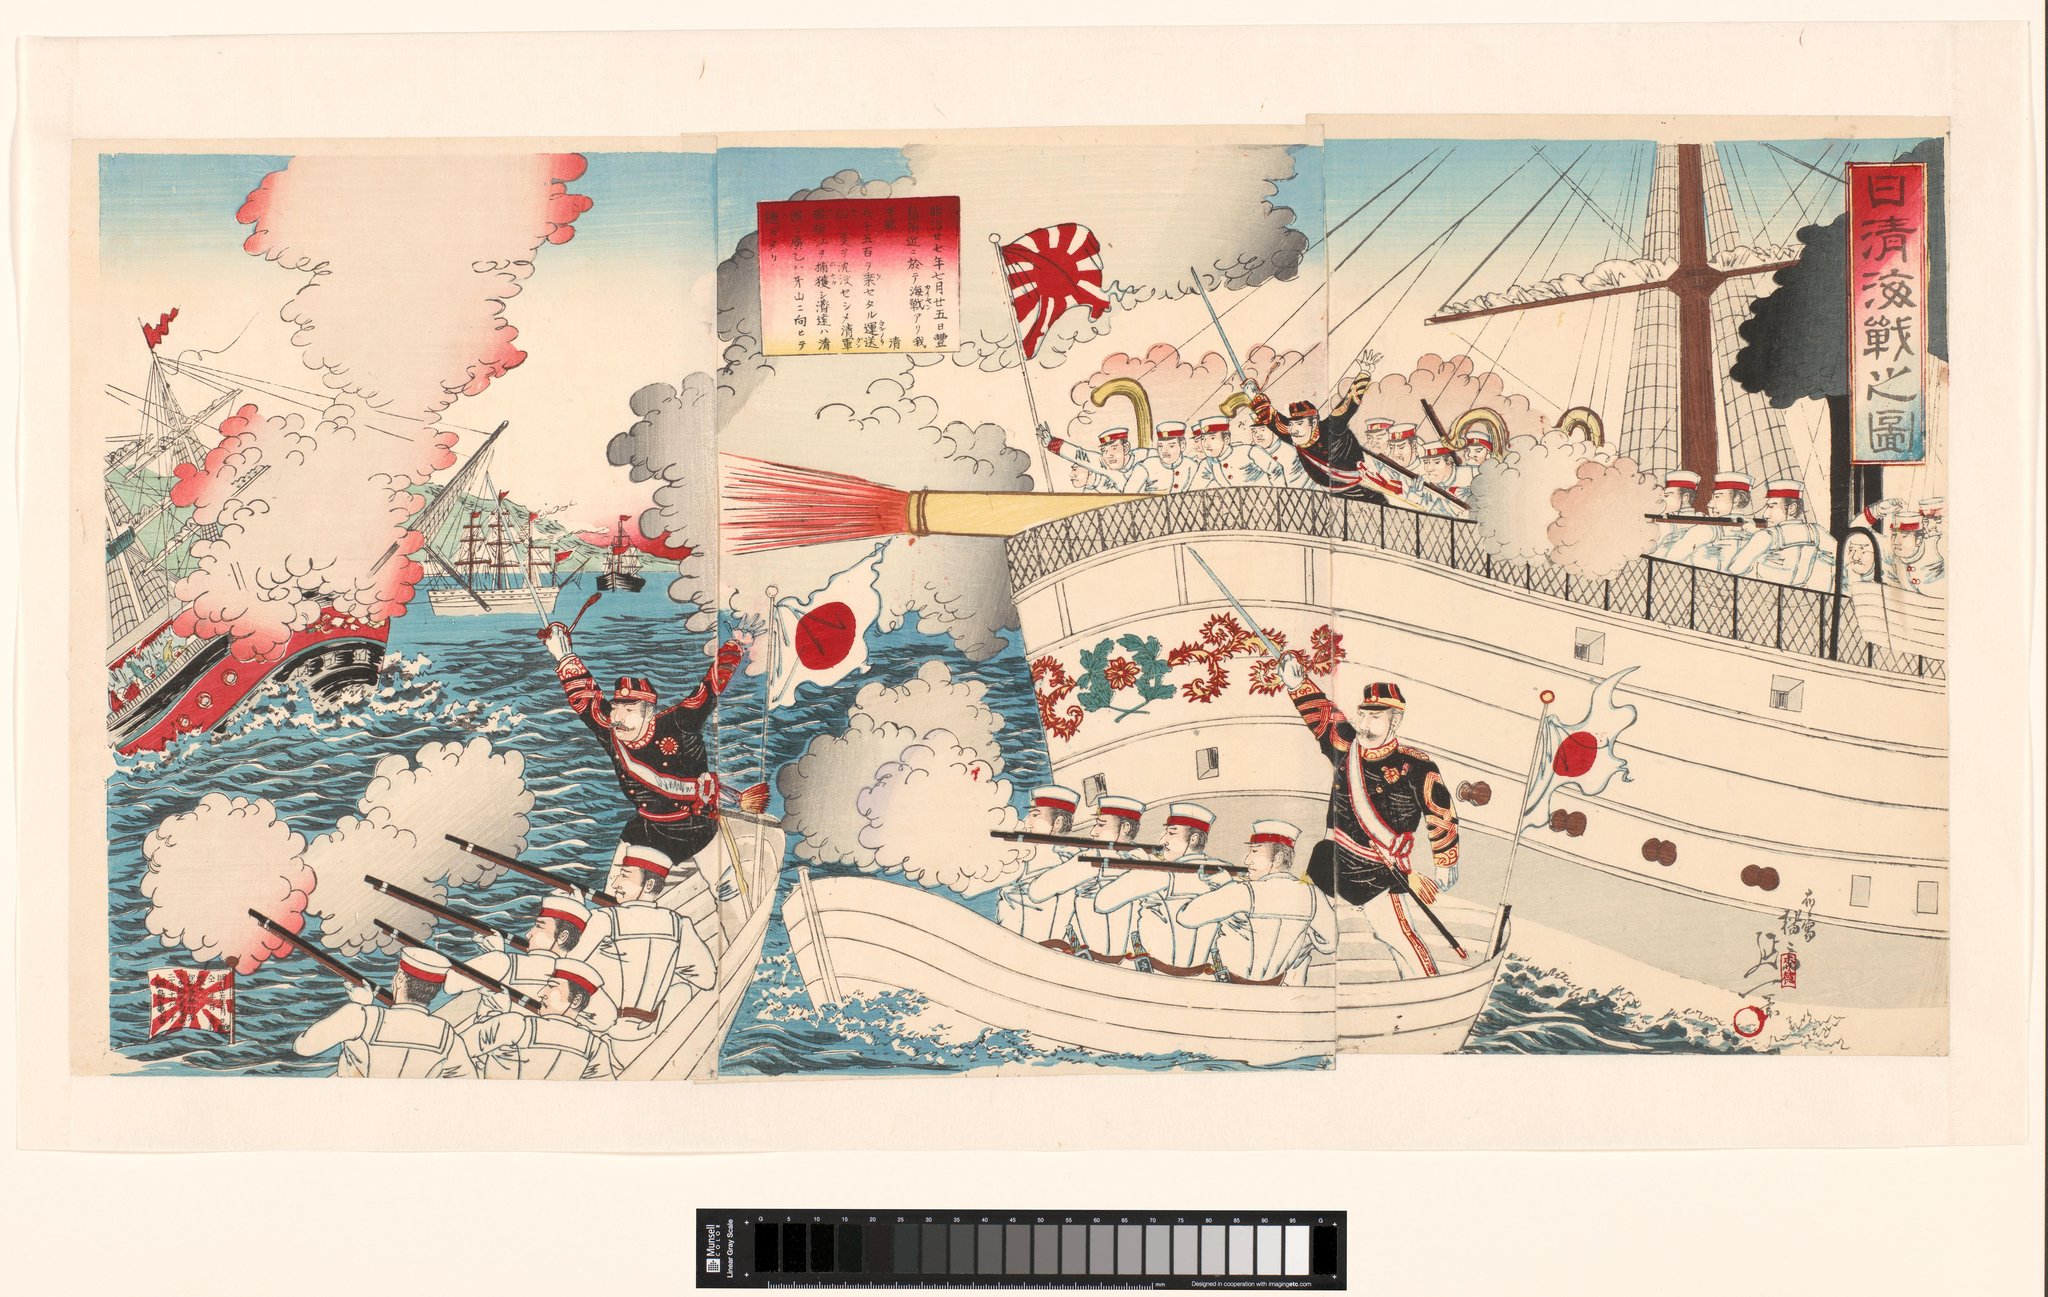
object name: print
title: Japanse oorlogsprent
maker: Anonymous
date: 1894-1905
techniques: woodcut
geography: japan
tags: war